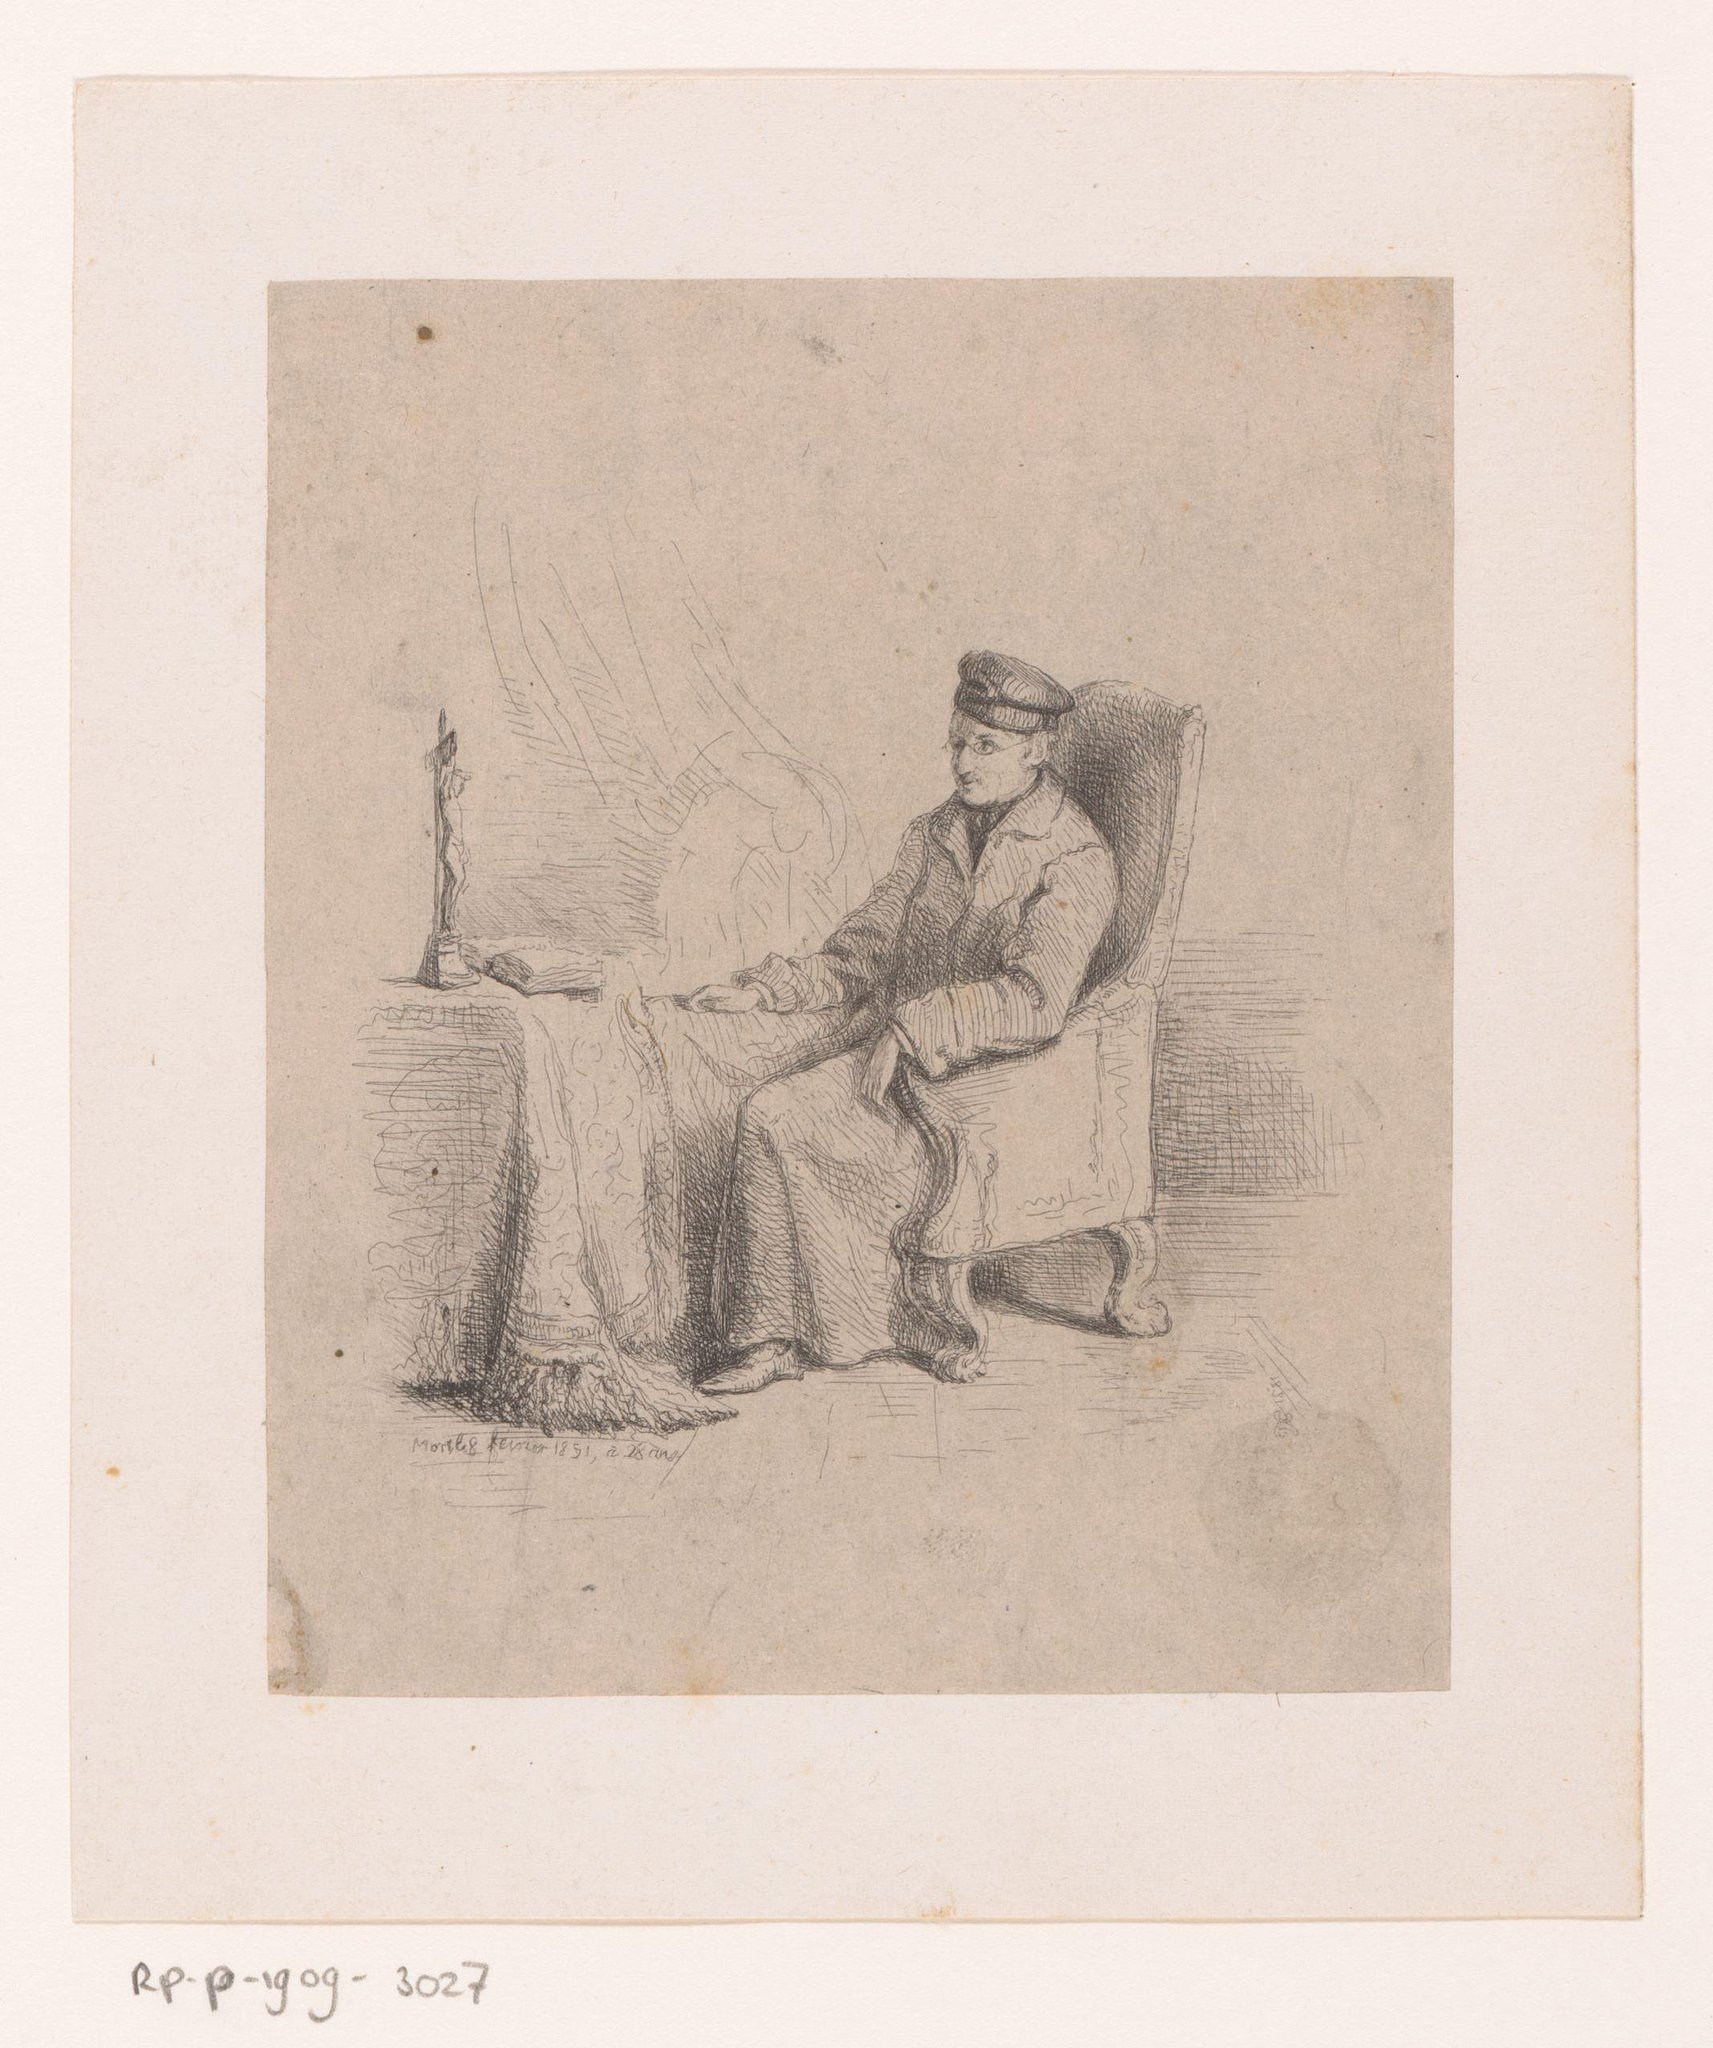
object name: print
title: Portret van een onbekende man zittend in zijn kamerjapon voor een crucifix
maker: joseph coomans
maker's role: draughtsman, painter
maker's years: 1816-1889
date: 1826-1889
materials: paper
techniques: etching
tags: historical persons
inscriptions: collector's mark: Lugt 1485, collector's mark: Lugt 2228